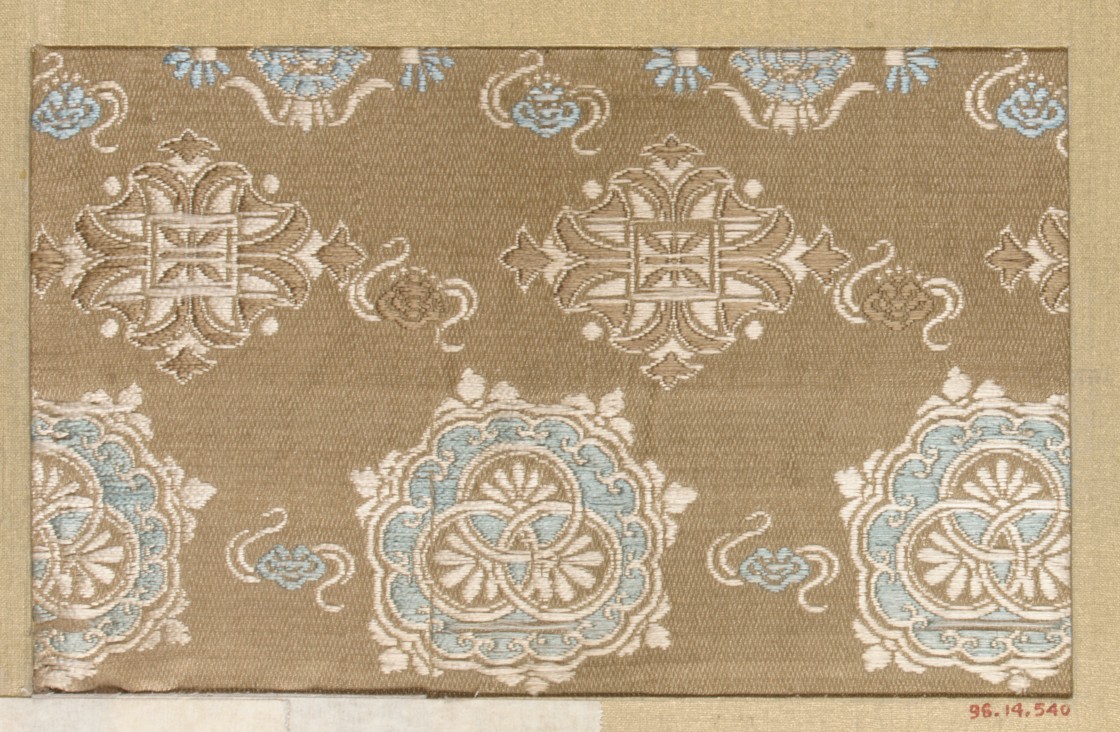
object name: piece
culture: japanese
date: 1701-1900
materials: silk